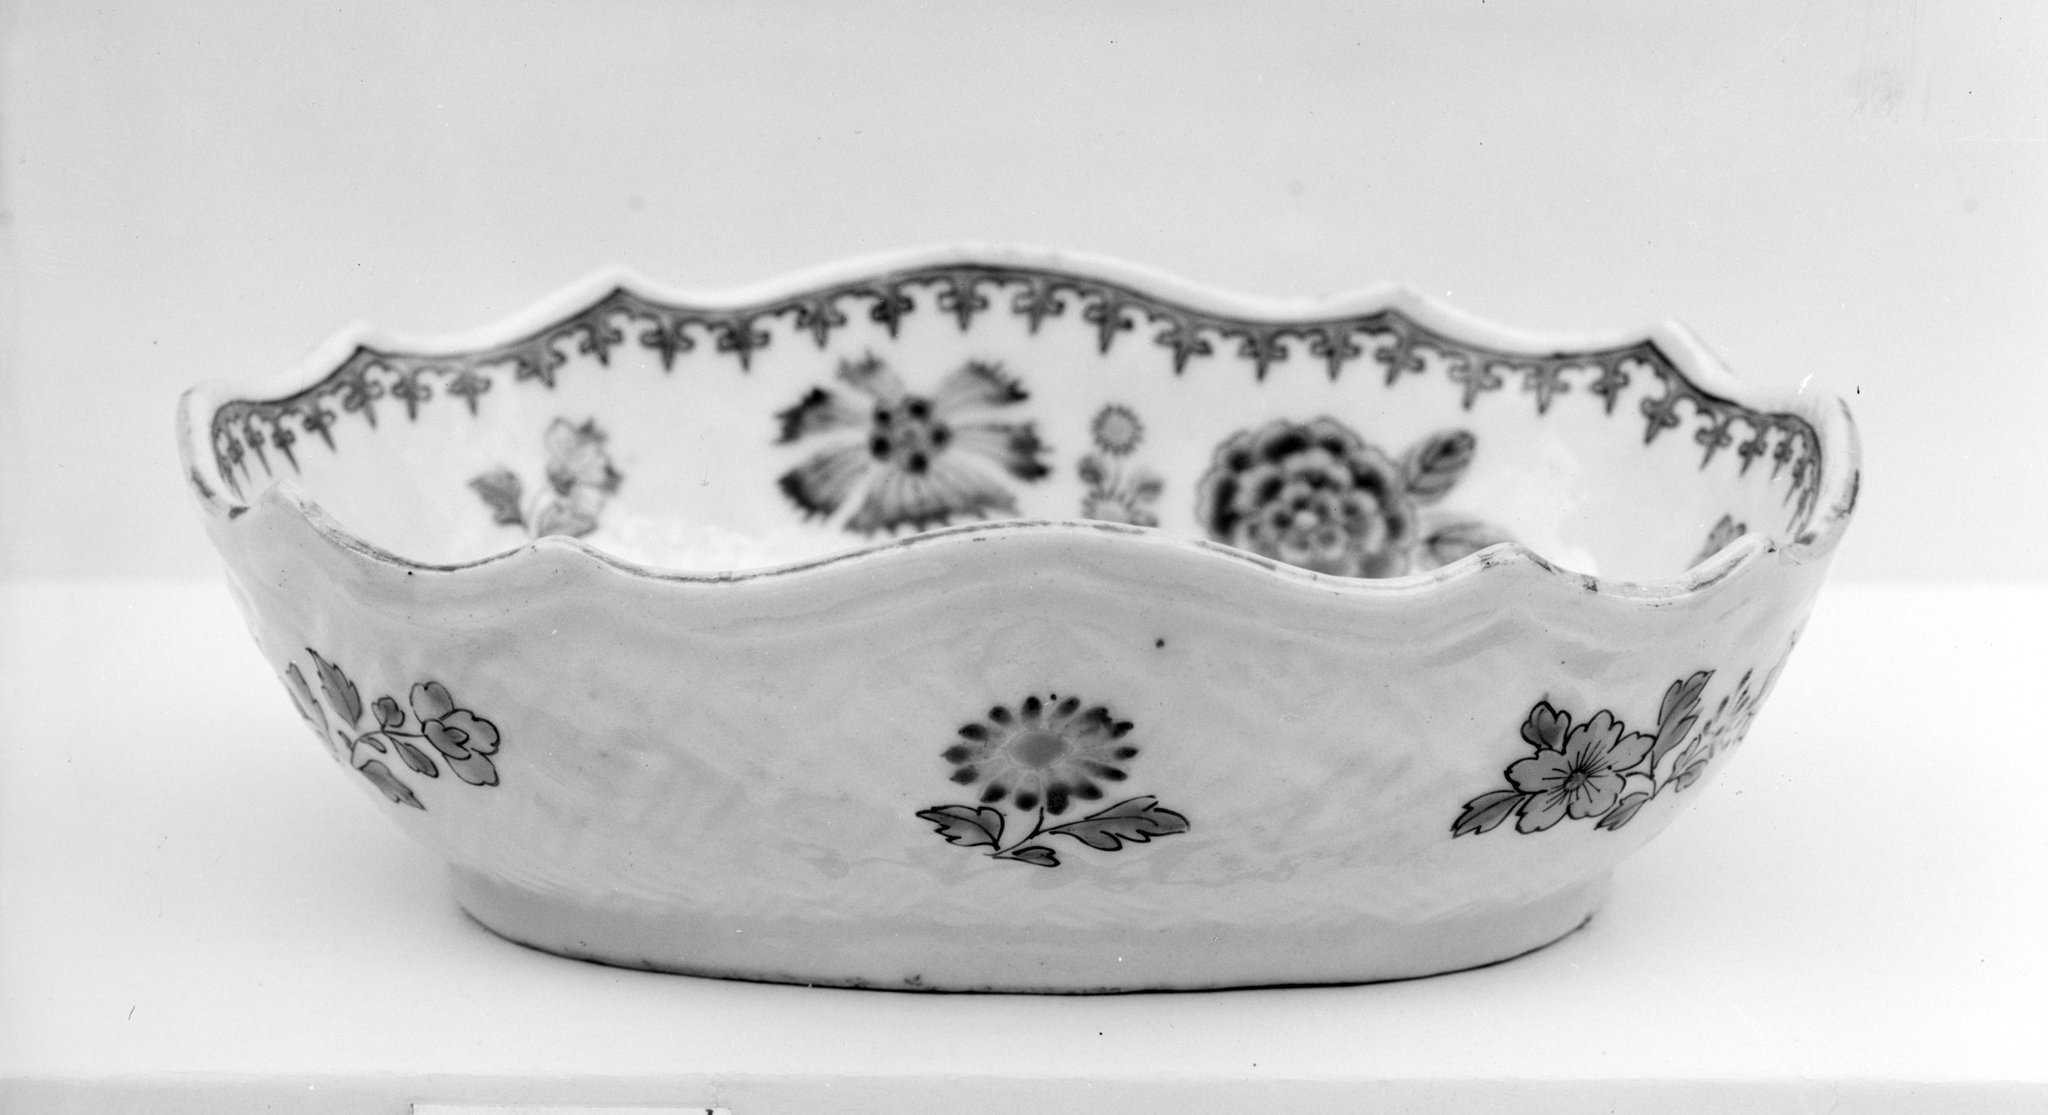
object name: dish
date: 1736-1795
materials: porcelain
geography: china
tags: flowers